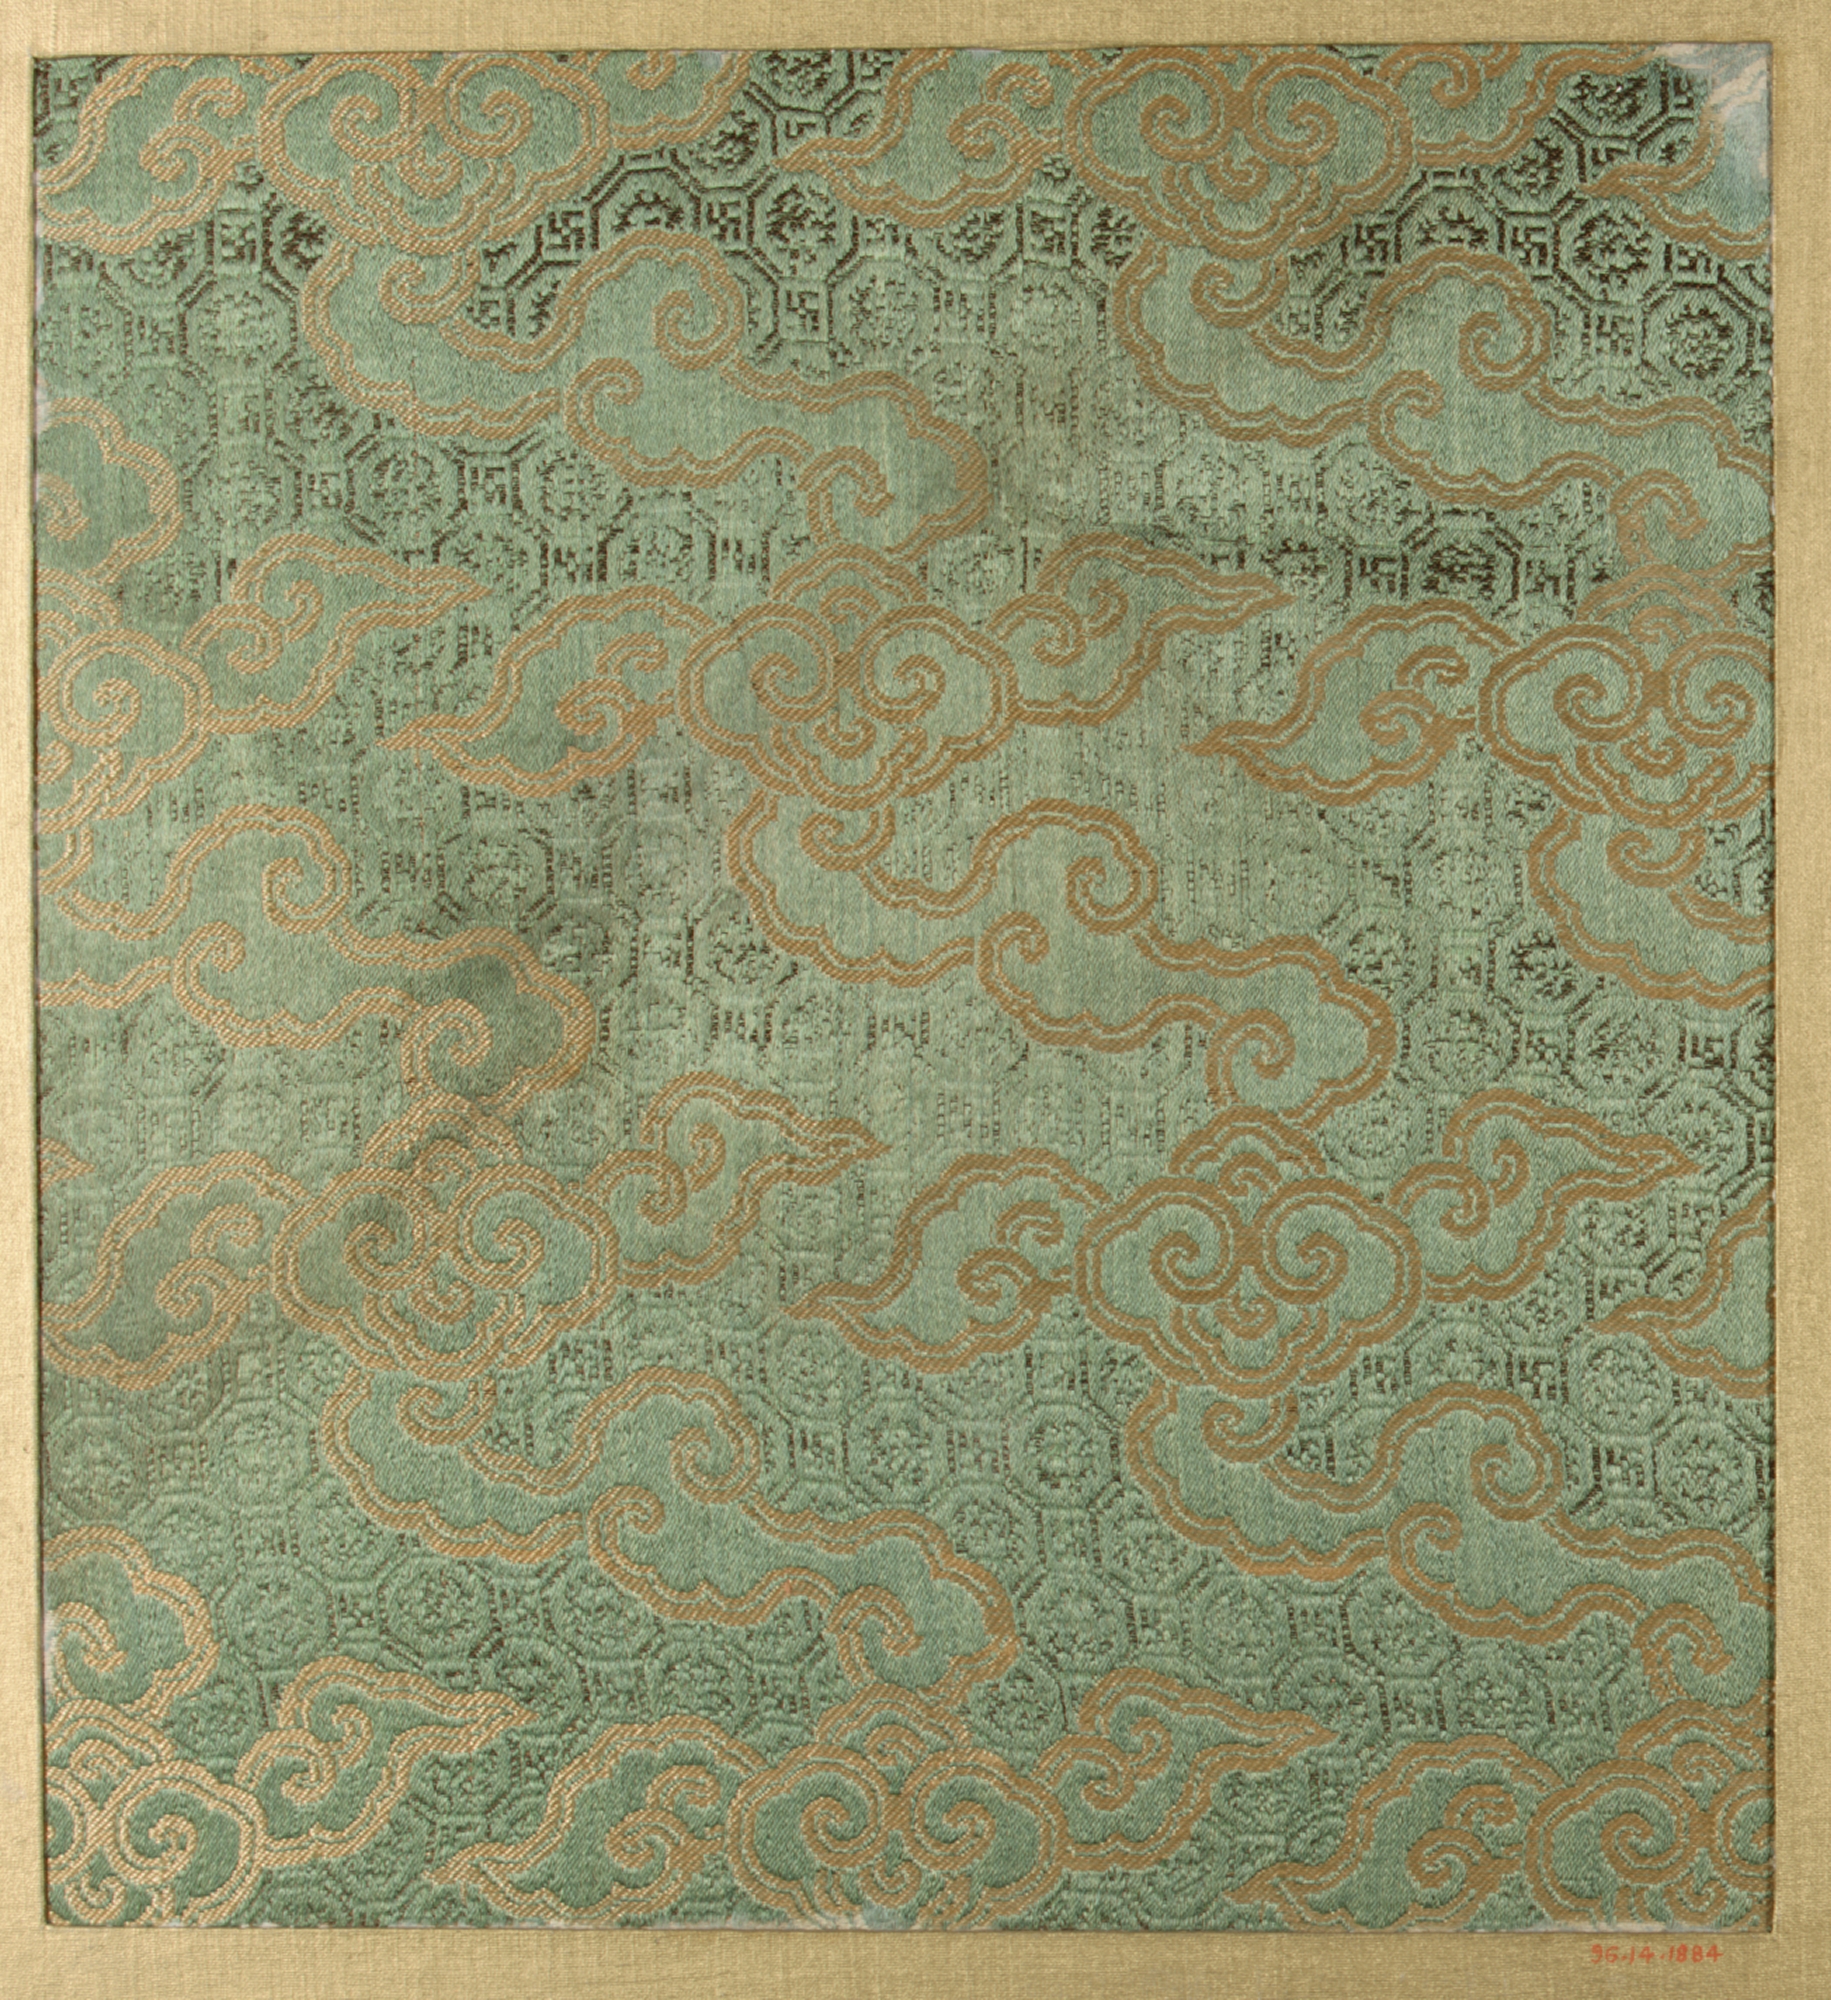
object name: piece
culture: japanese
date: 1701-1900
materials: silk